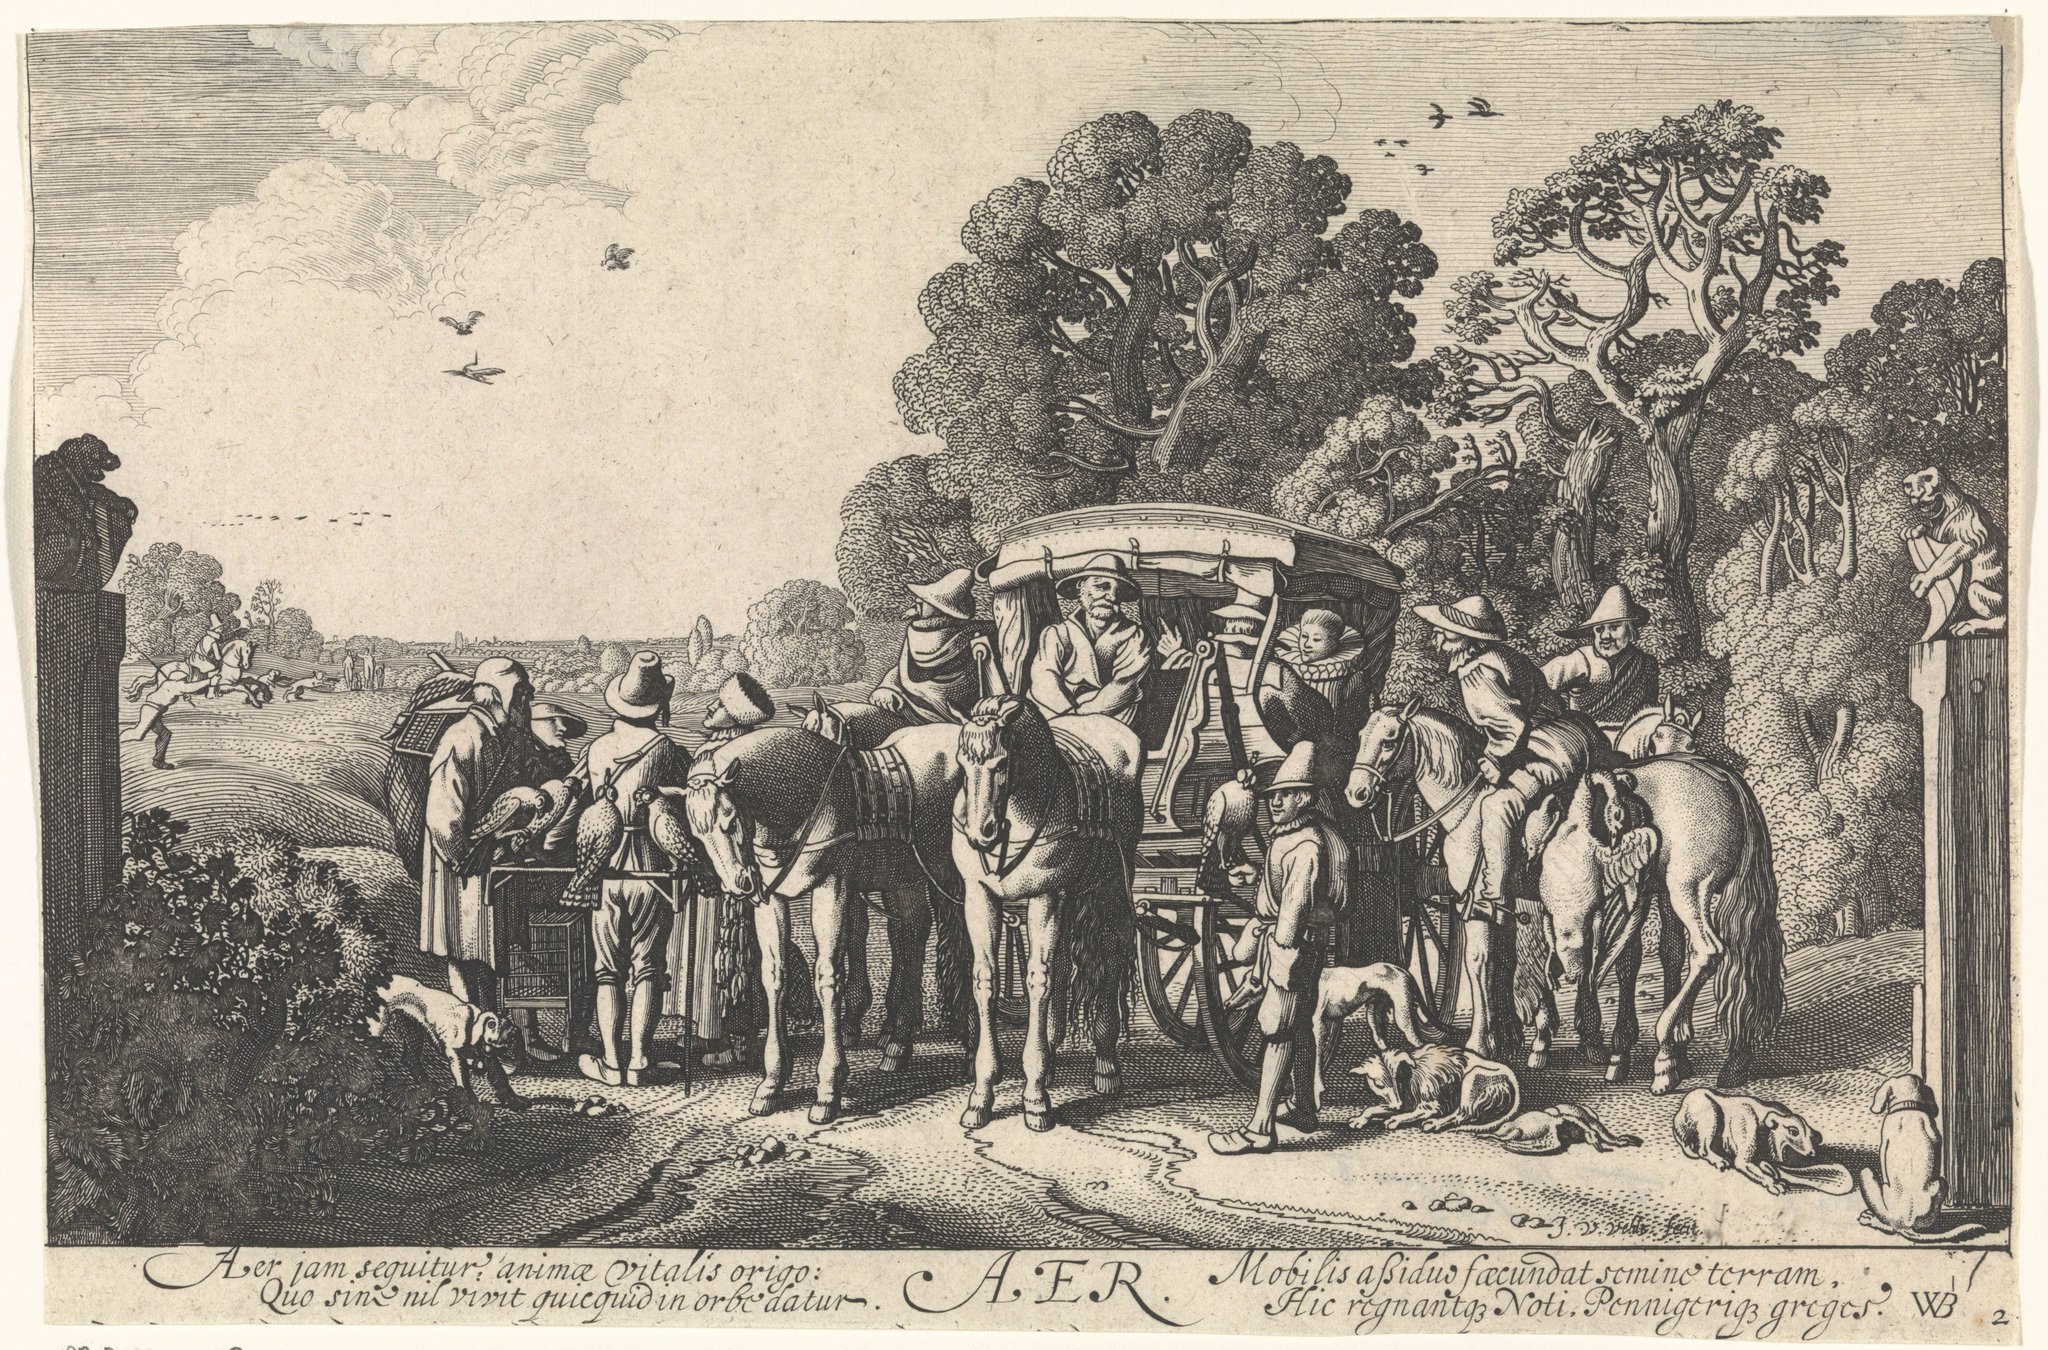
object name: print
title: Lucht (Aer)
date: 1603-1641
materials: paper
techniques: engraving, etching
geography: northern netherlands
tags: predatory birds: falcon, hunting, chase, air (one of the four elements), game, hunted animals, bird hunting, four-wheeled vehicle drawn by two animals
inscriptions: collector's mark: Lugt 2228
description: Landschap met figuren tijdens een valkenjacht voorstellende het element lucht. Op een landweg staat een stilstaande reiskoets met twee paarden ervoor. Een groep valkeniers eromheen. Tweede prent uit een serie van vier met landschappen als verbeeldingen van de vier elementen.